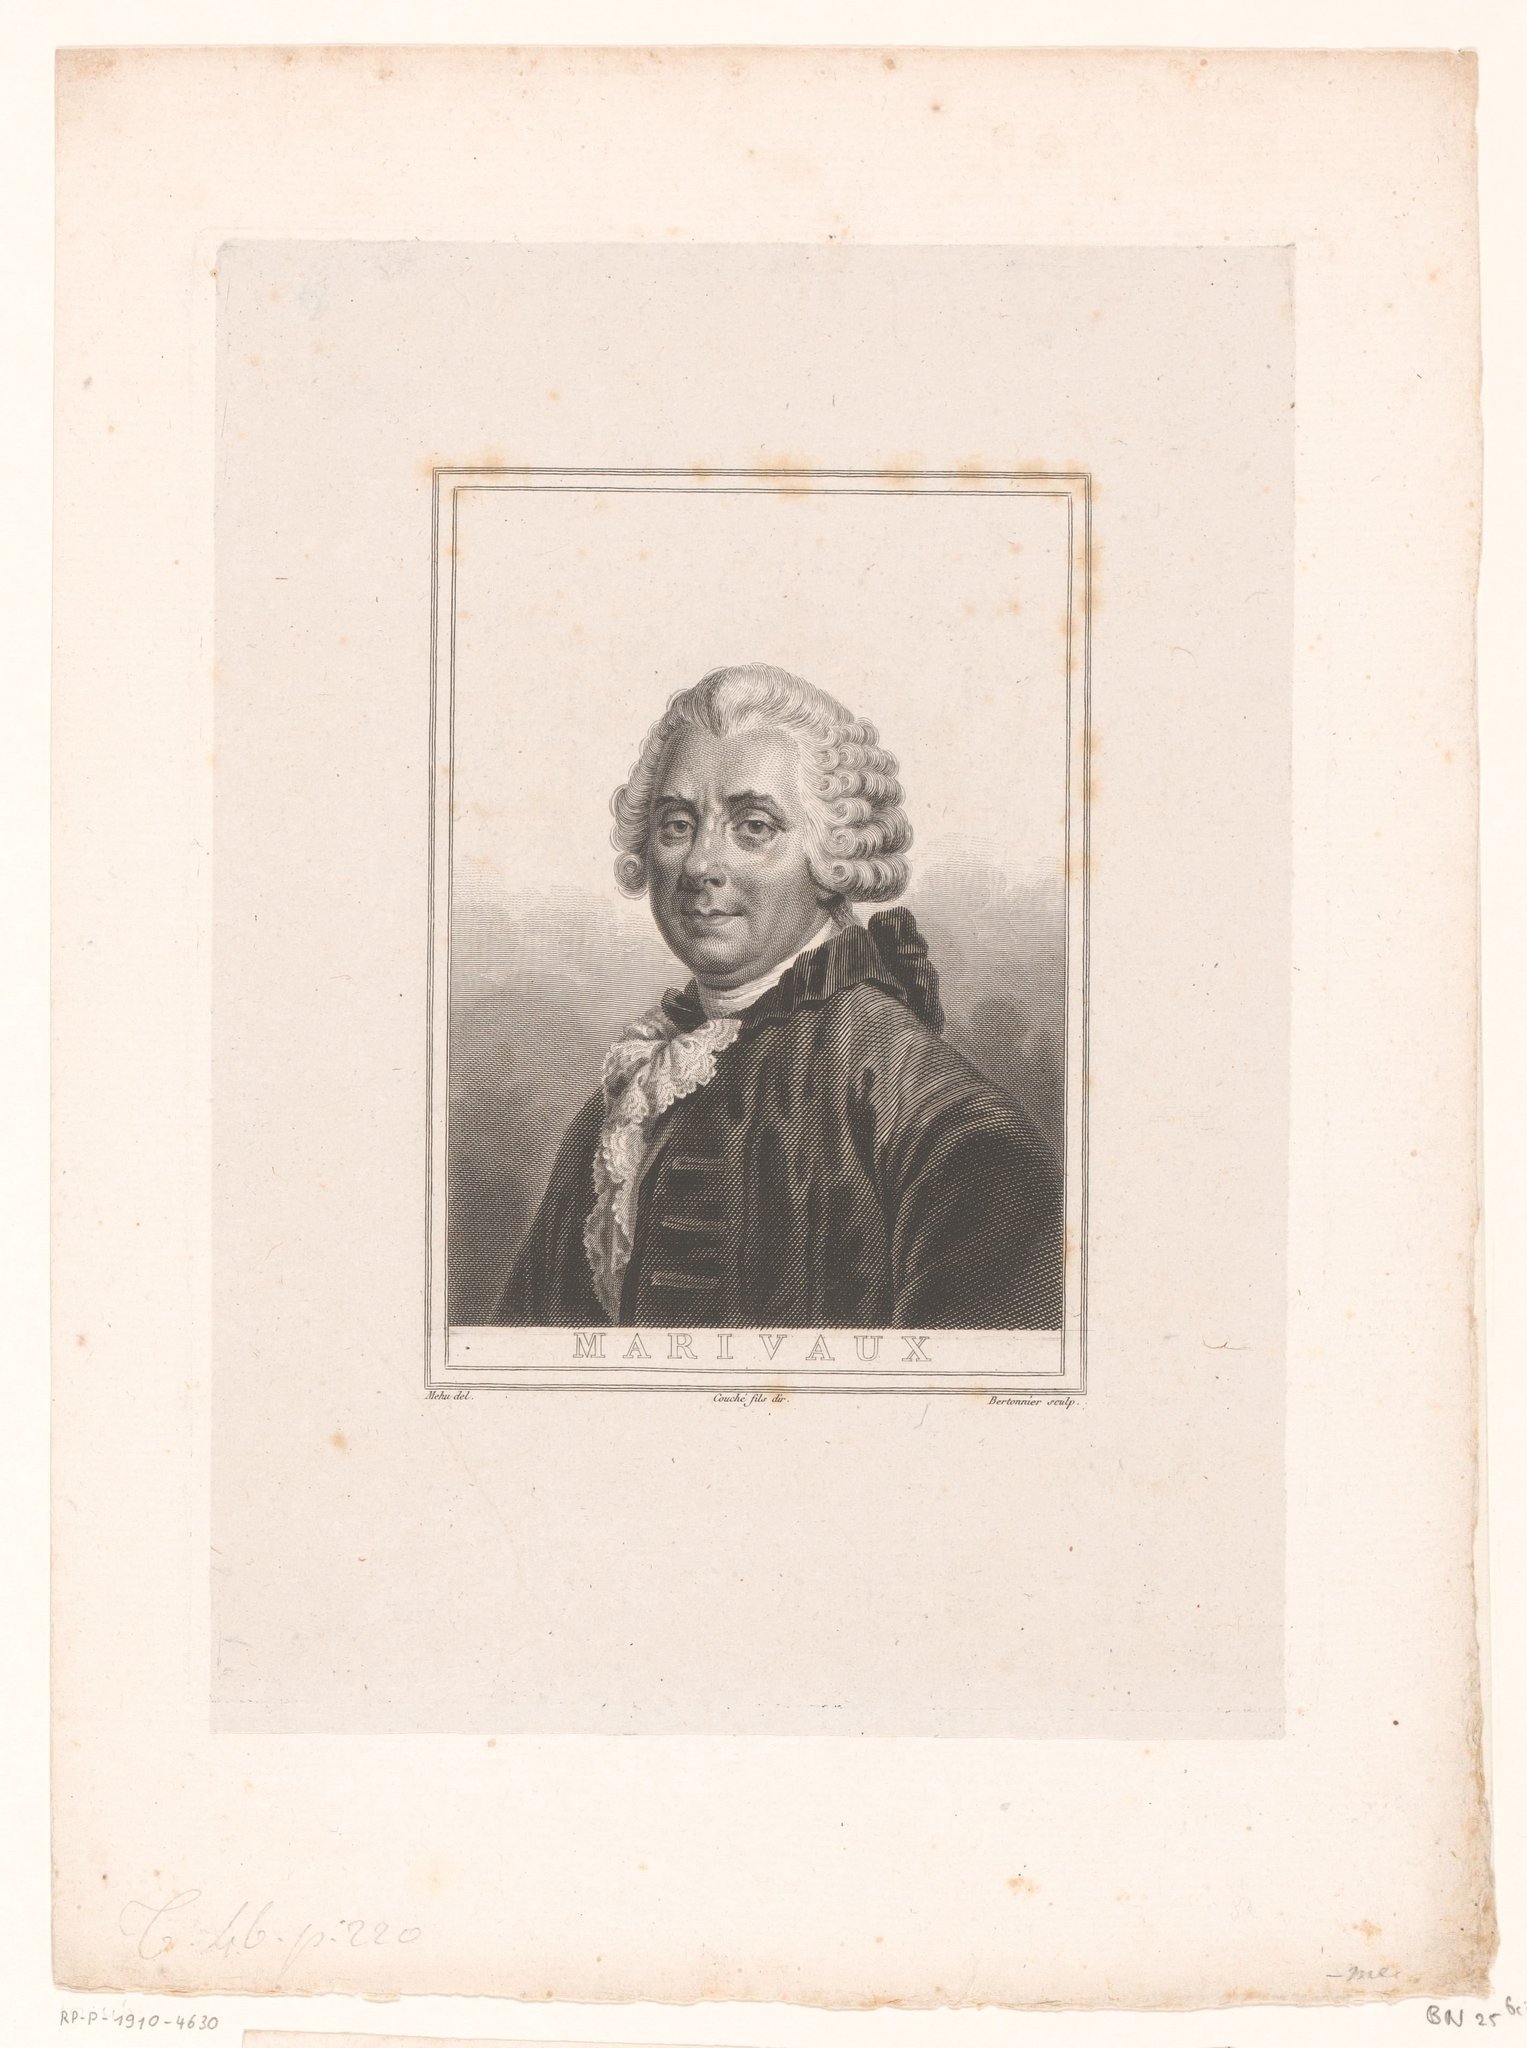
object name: print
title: Portret van Pierre Carlet de Marivaux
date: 1824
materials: paper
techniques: engraving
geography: france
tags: paris, historical persons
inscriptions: collector's mark: Lugt 2228